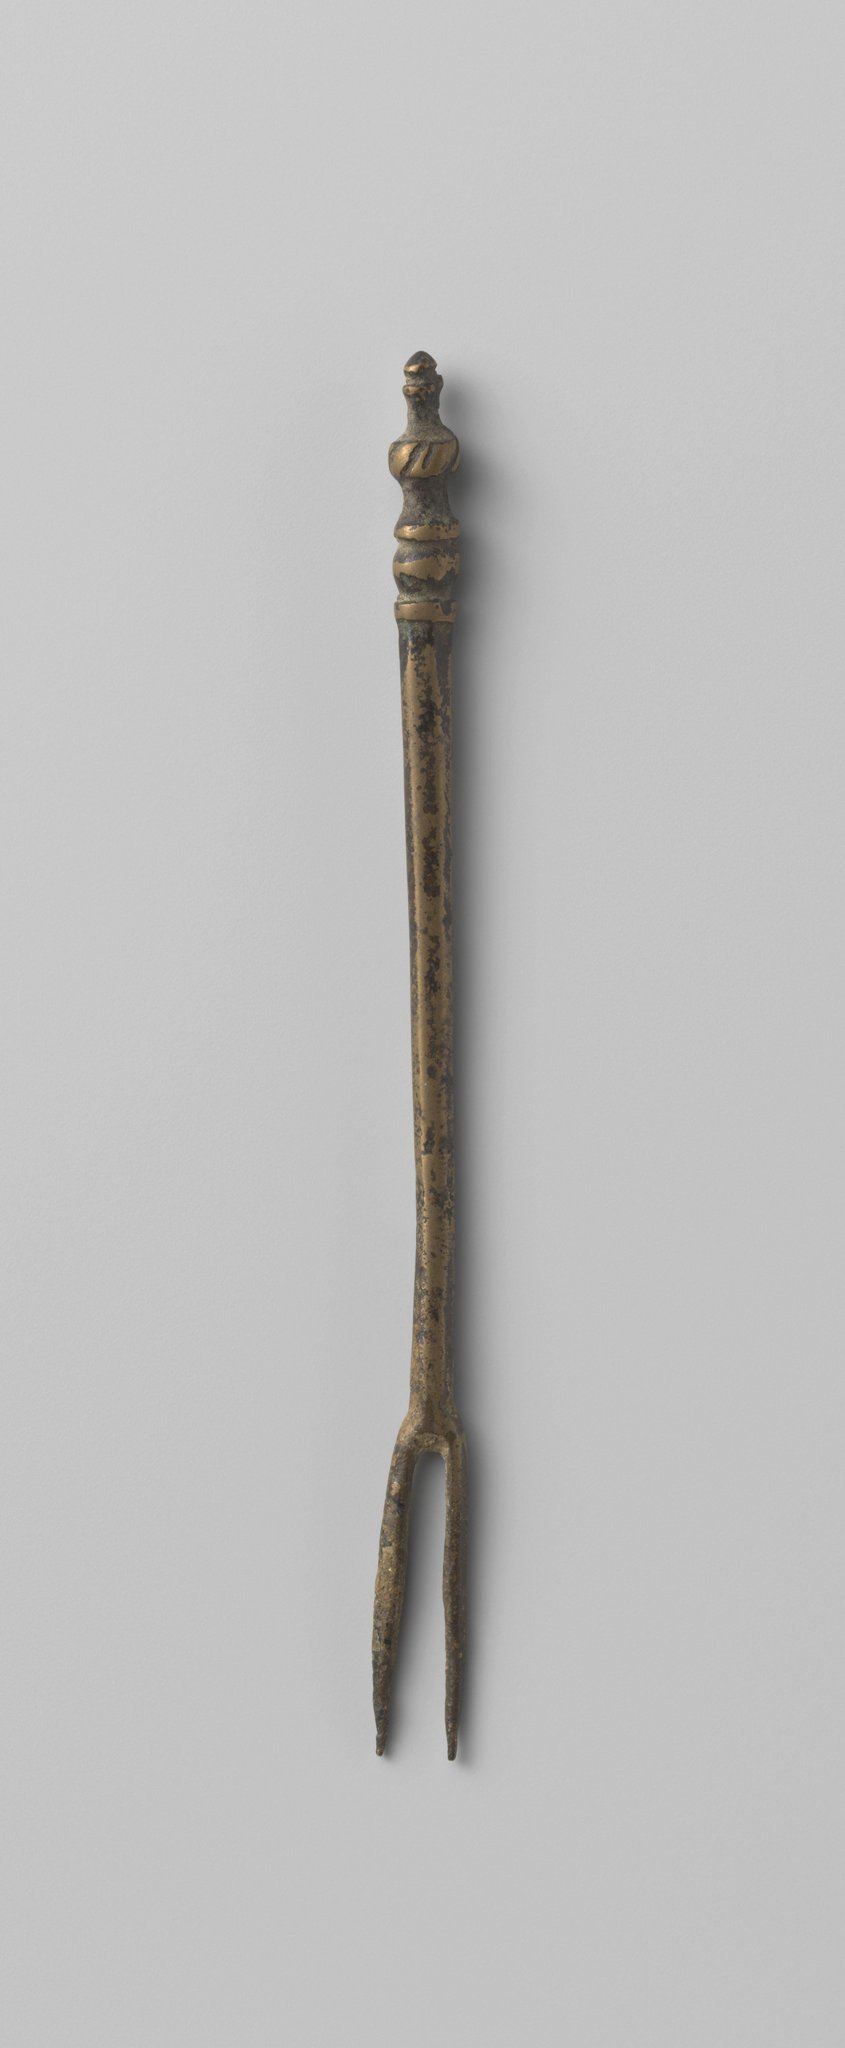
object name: fork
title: Vork met twee tanden en vaasvormige versiering aan uiteinde steel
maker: Anonymous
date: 1600-1699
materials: brass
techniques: casting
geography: western europe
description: De gegoten vork heeft twee tanden en een ronde steel eindigend in een vaasvormige versiering.